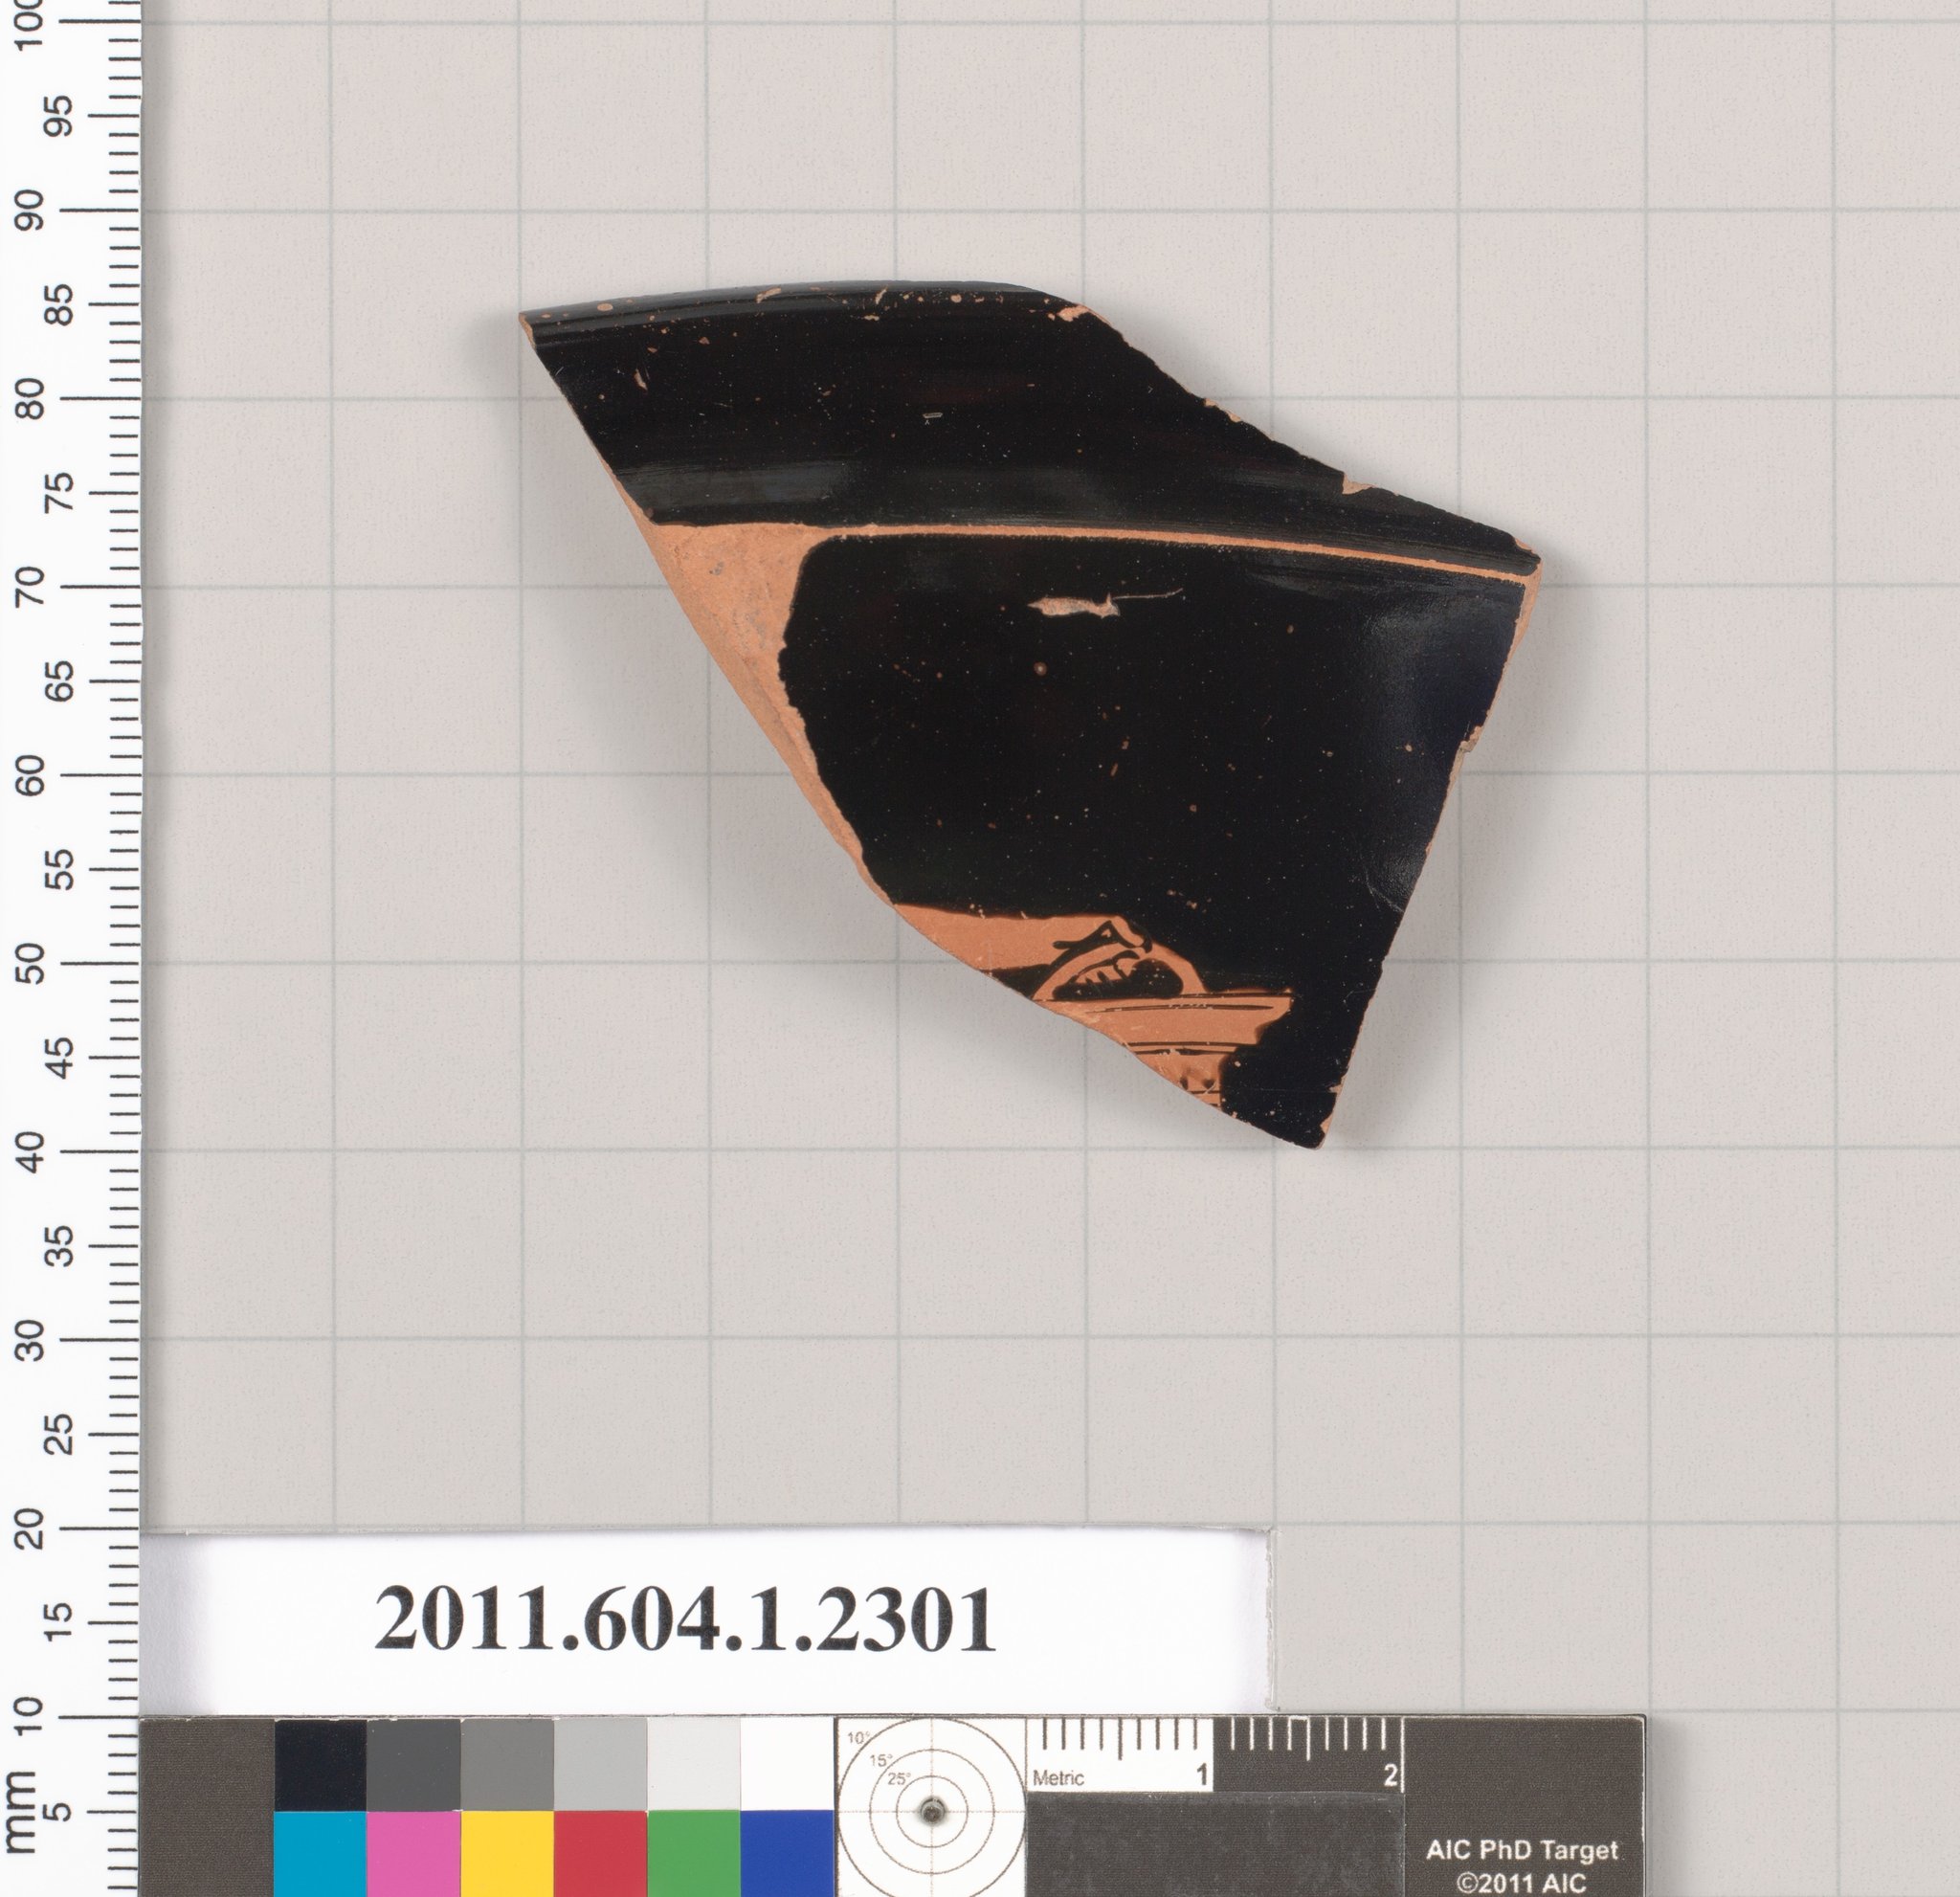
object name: kylix fragment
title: Terracotta rim fragment of a kylix (drinking cup)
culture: greek, attic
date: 490-480 BCE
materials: terracotta